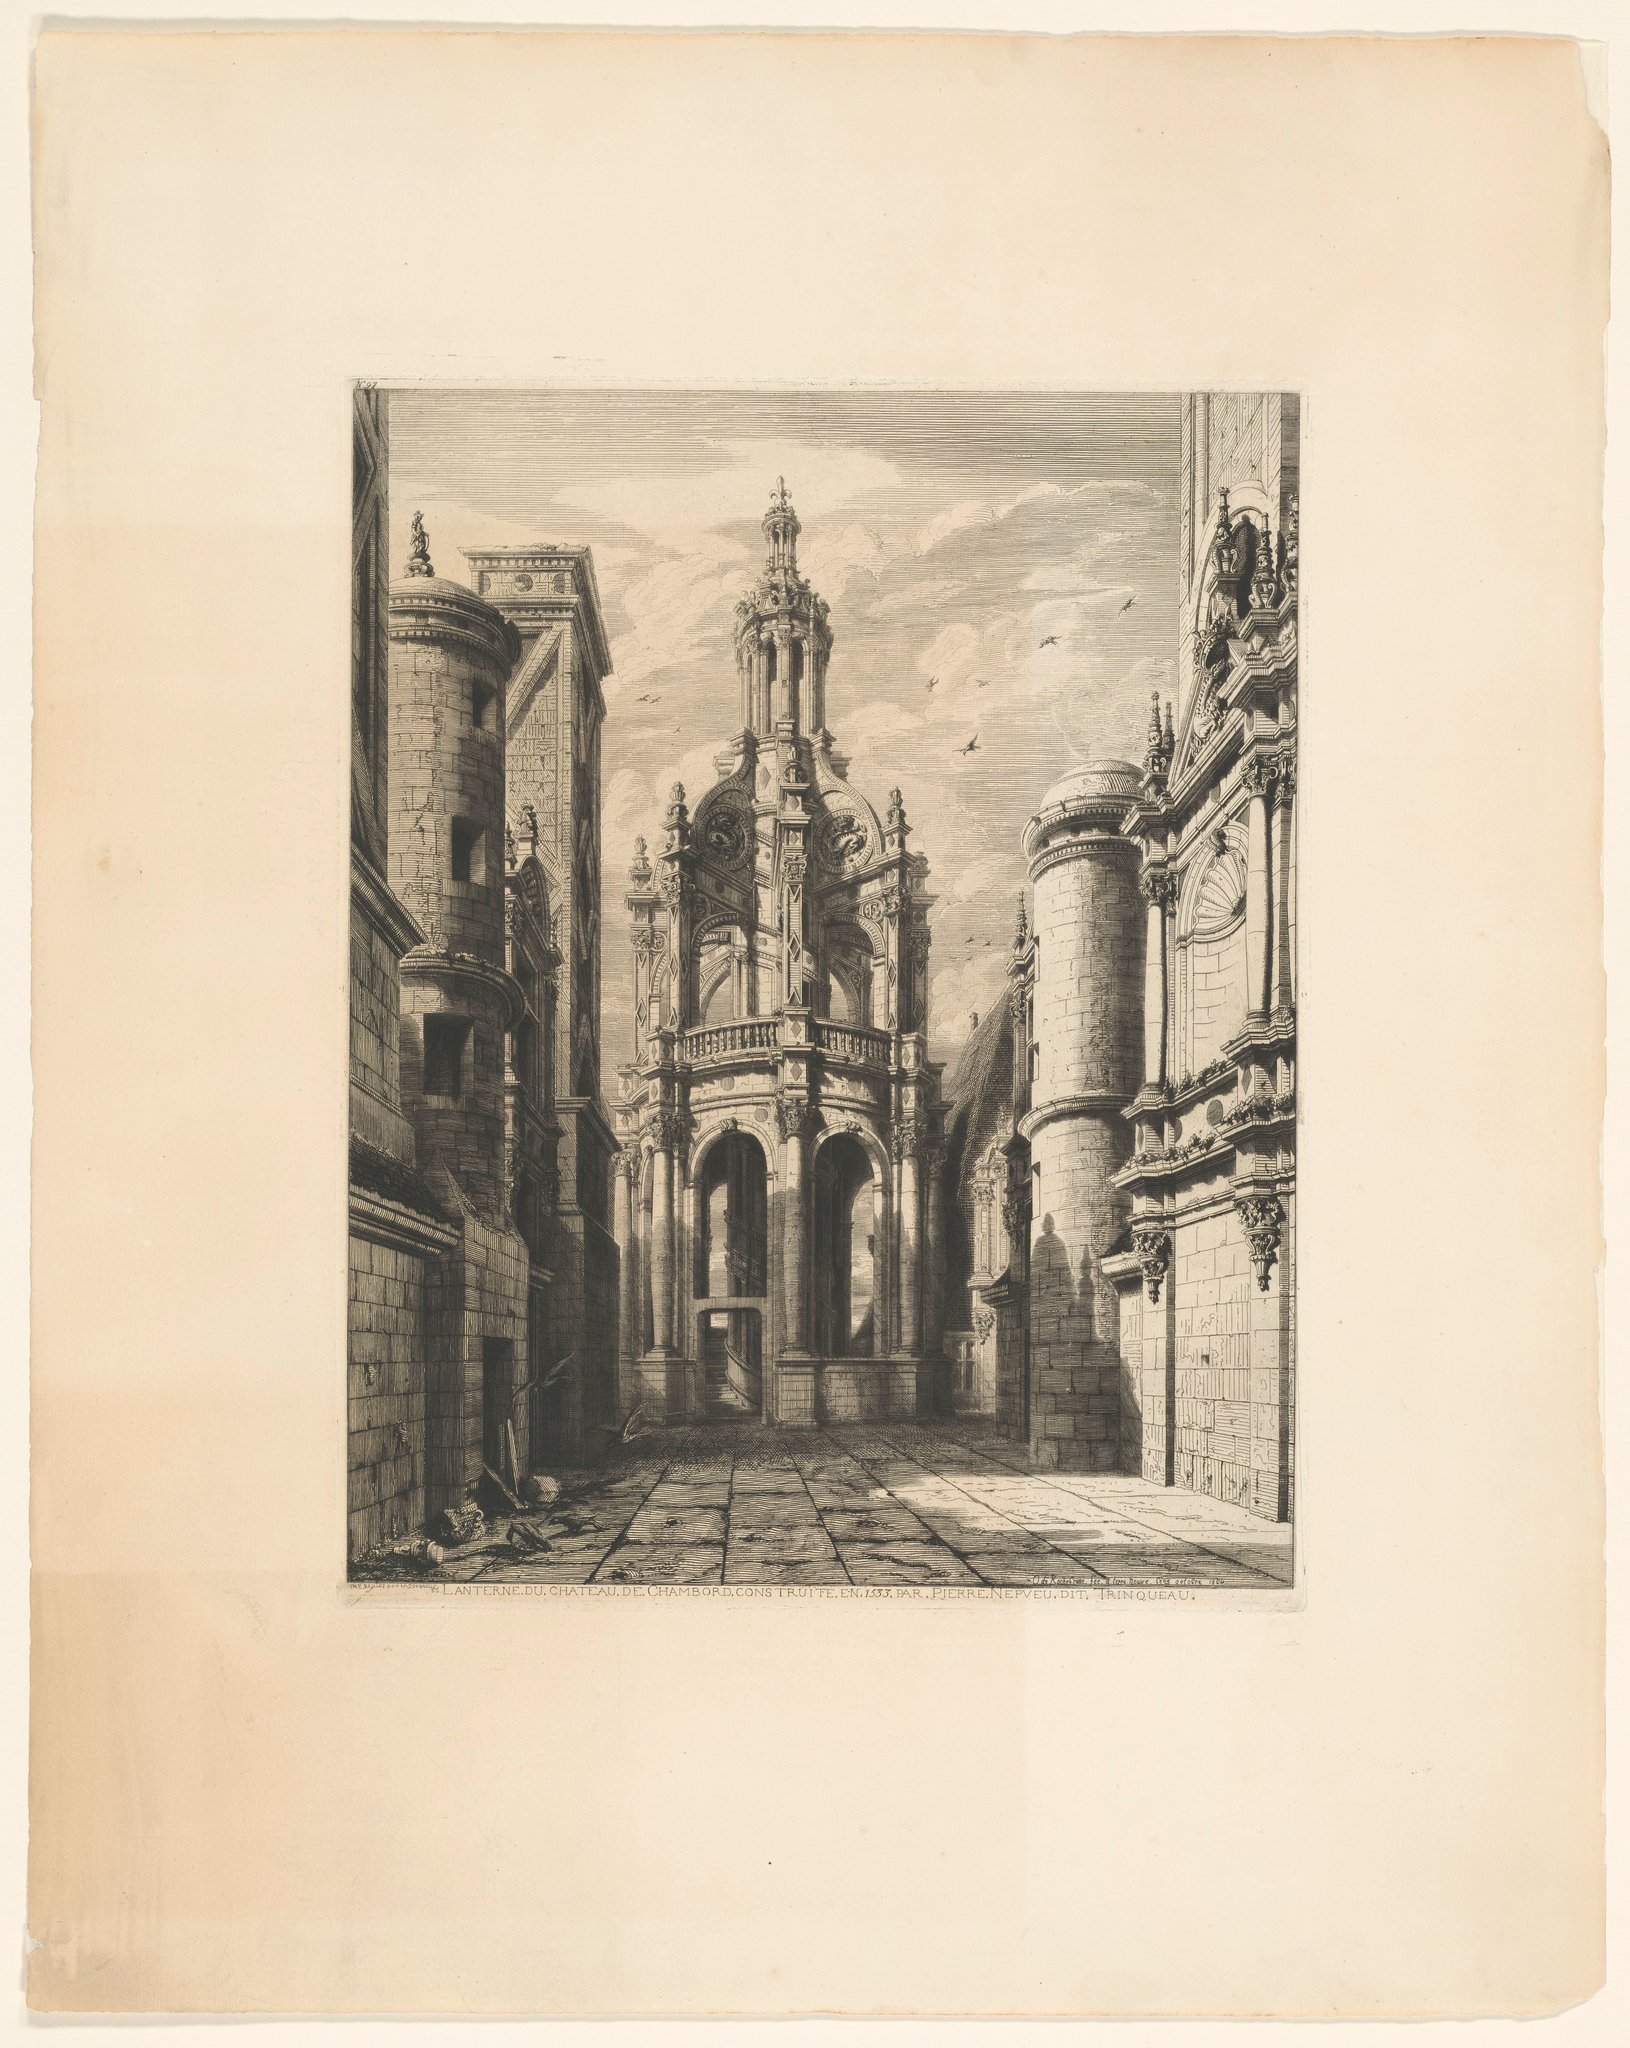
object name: print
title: Lanterne du Chateau de Chambord, construite en 1533 par Pierre Nepveu dit Trinqueau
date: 1864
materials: paper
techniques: etching, retroussage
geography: paris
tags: castle, staircase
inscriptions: collector's mark: Lugt 2233